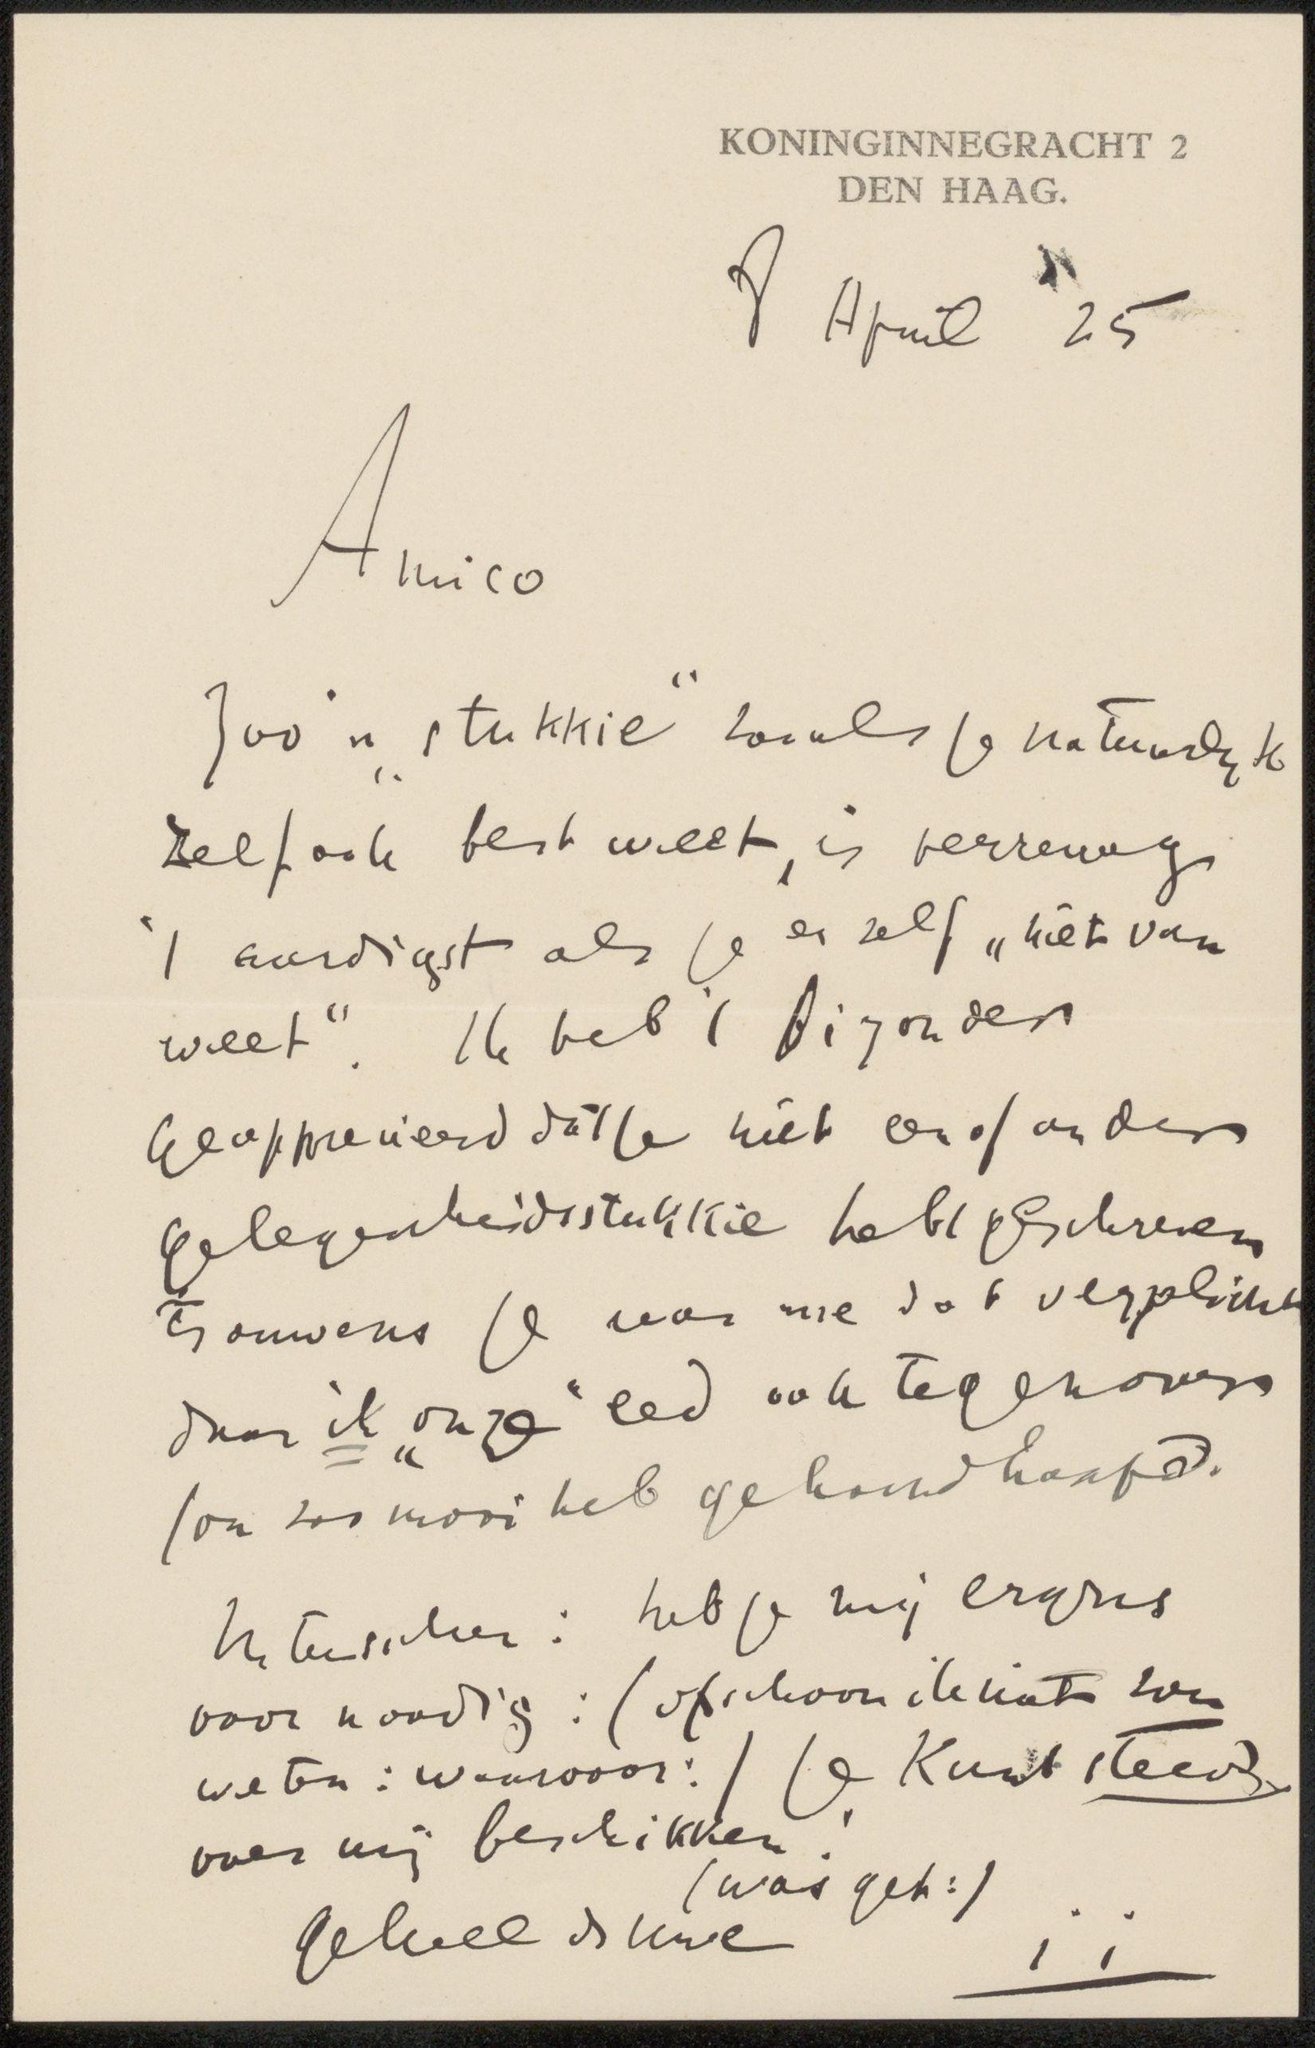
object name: letter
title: Brief aan Jan Veth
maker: isaac israels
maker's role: draughtsman, painter, print maker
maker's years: 1865-1934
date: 1925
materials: ink, paper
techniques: pen, printing, writing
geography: the hague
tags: dordrecht, amsterdam, painter, print maker, draughtsman, designer, jan veth, printed matter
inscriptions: collector's mark: ‘RPK’